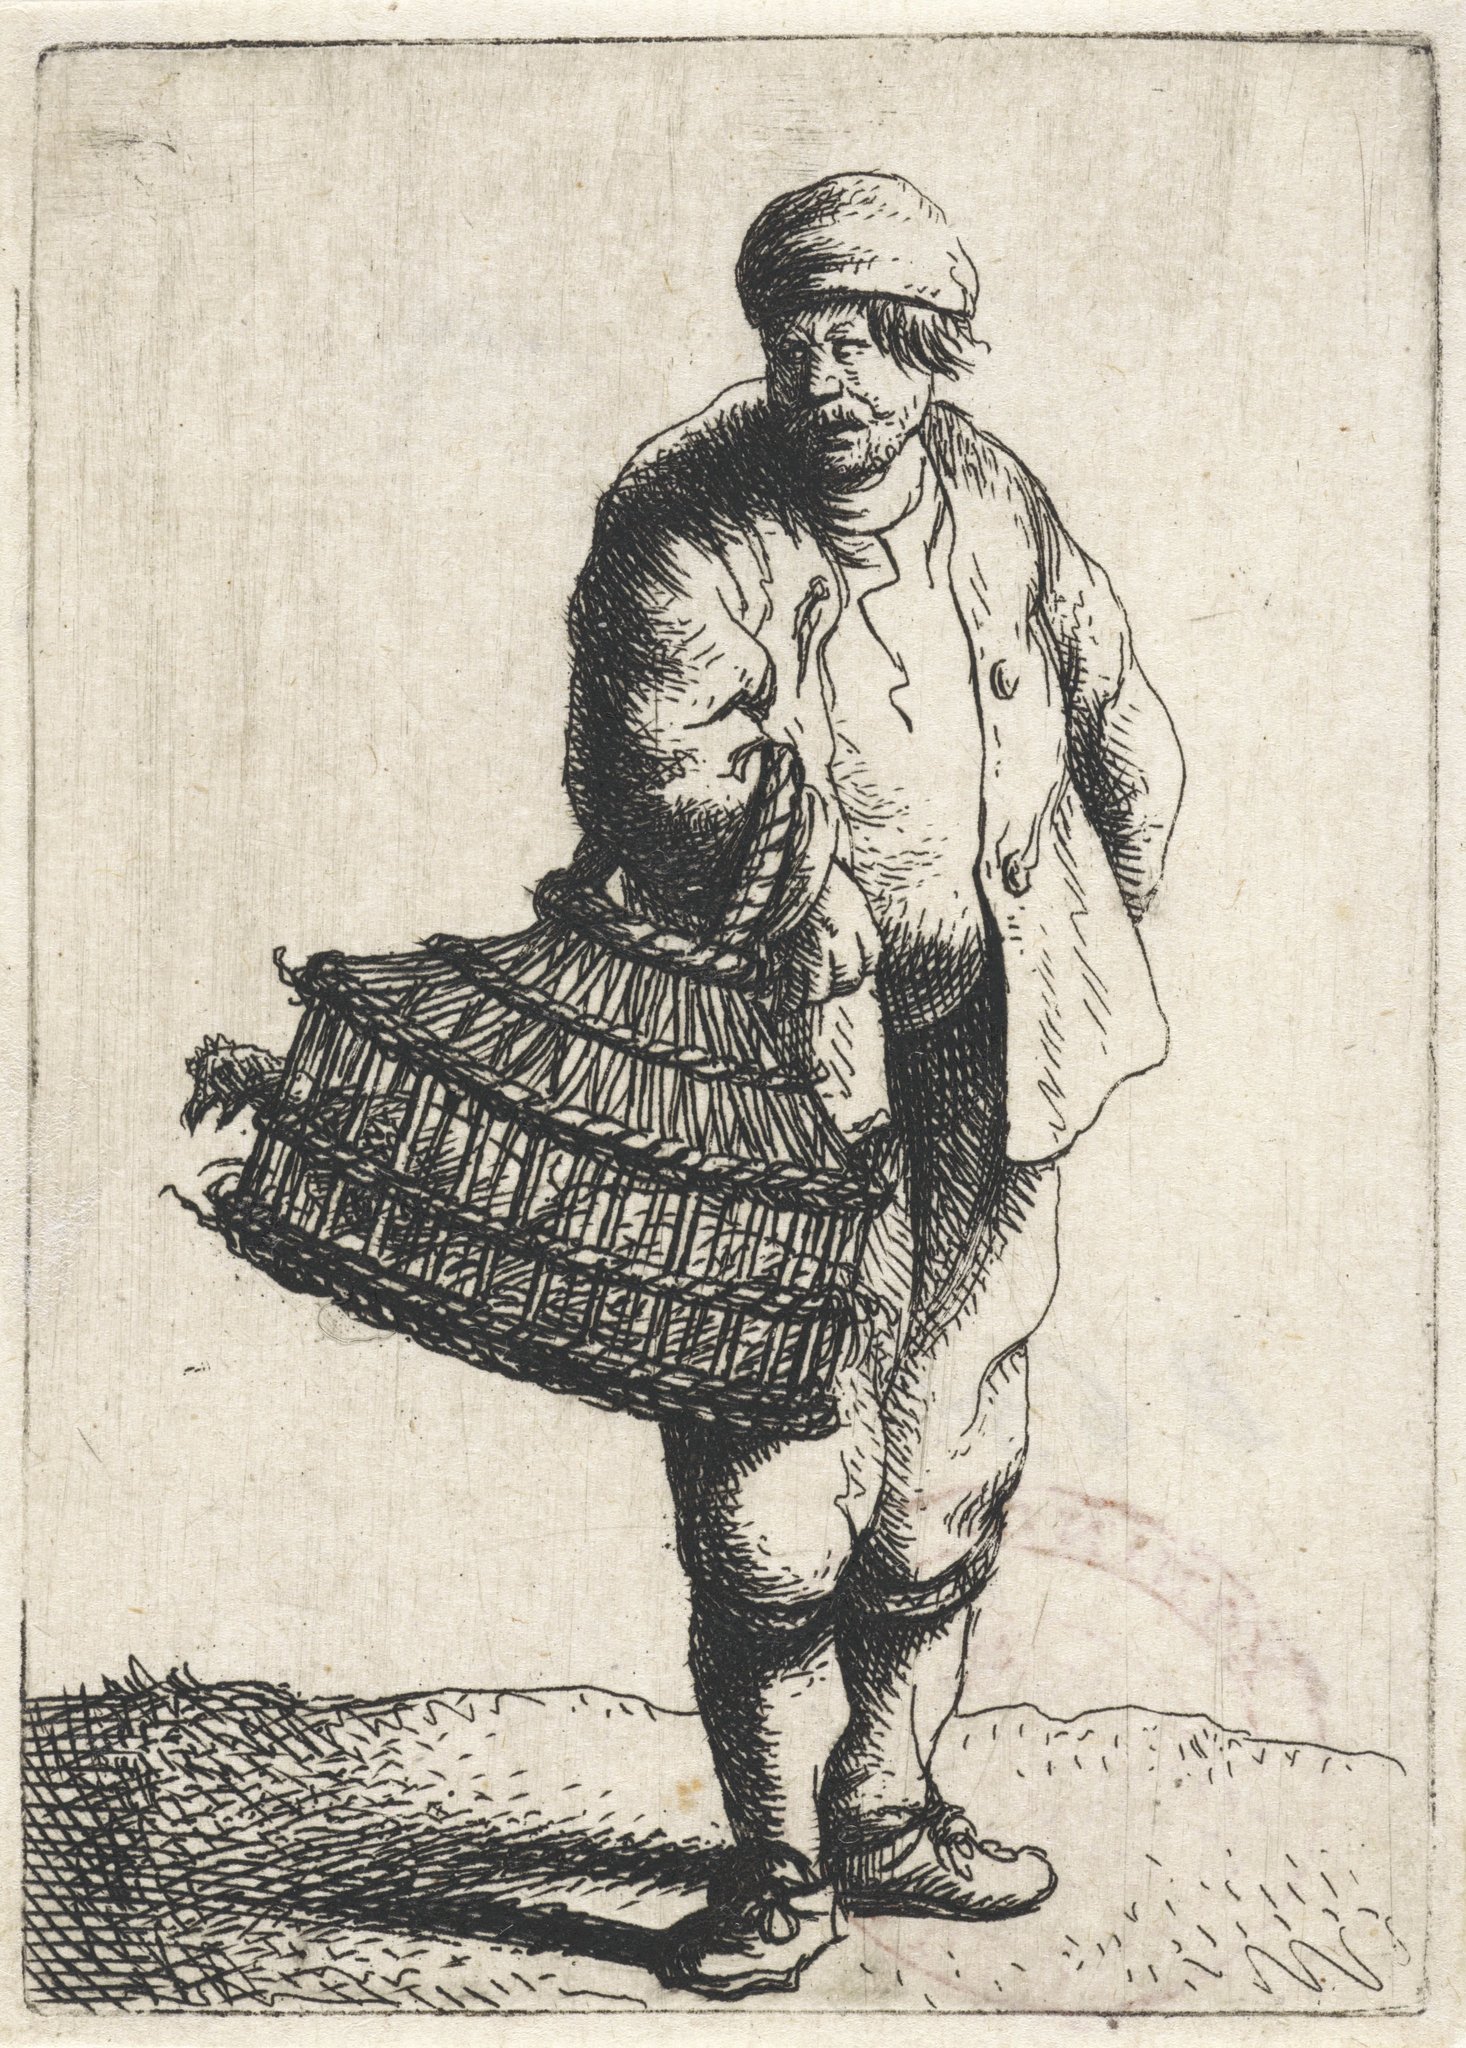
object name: print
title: Man draagt mand met kippen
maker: jan gillisz. van vliet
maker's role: draughtsman, painter, print maker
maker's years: 1600-1668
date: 1635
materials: paper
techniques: etching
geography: leiden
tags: container made of plant material other than wood: basket, fowl (cock, hen, chicken, etc.)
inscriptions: collector's mark: Lugt 240